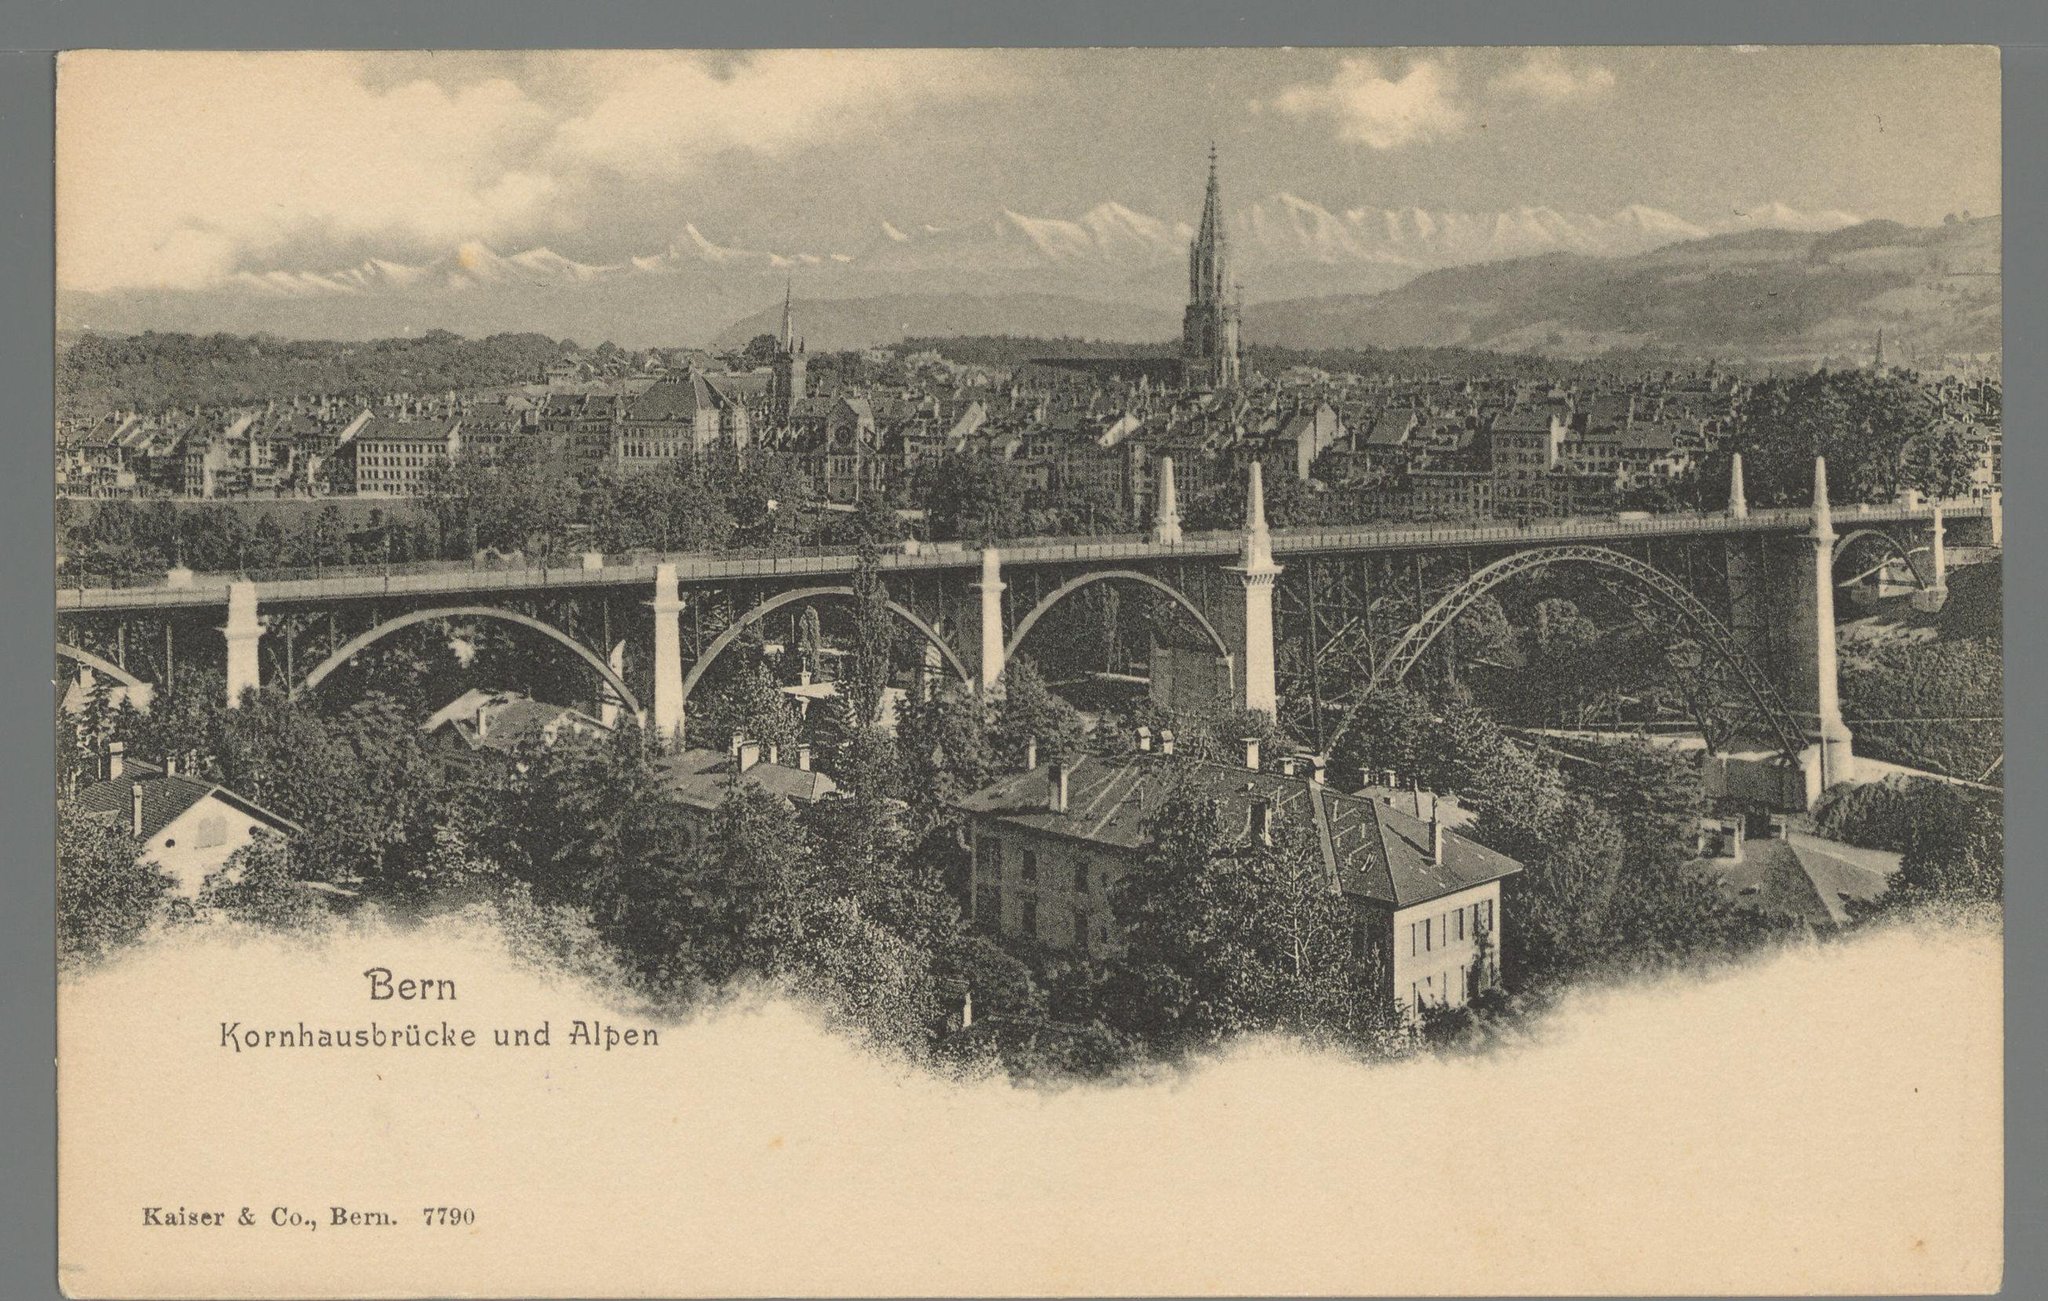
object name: ansichtkaart, prentbriefkaart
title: Bern. Kornhausbrücke und Alpen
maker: Anonymous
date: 1903-1904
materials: cardboard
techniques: photograph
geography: bern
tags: church (exterior), mountain-range, snow peaks, prospect of city, town panorama, silhouette of city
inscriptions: stamp: ‘Congrès International de l'enseignement du dessin. 3 aout 1904. Berne 1904’